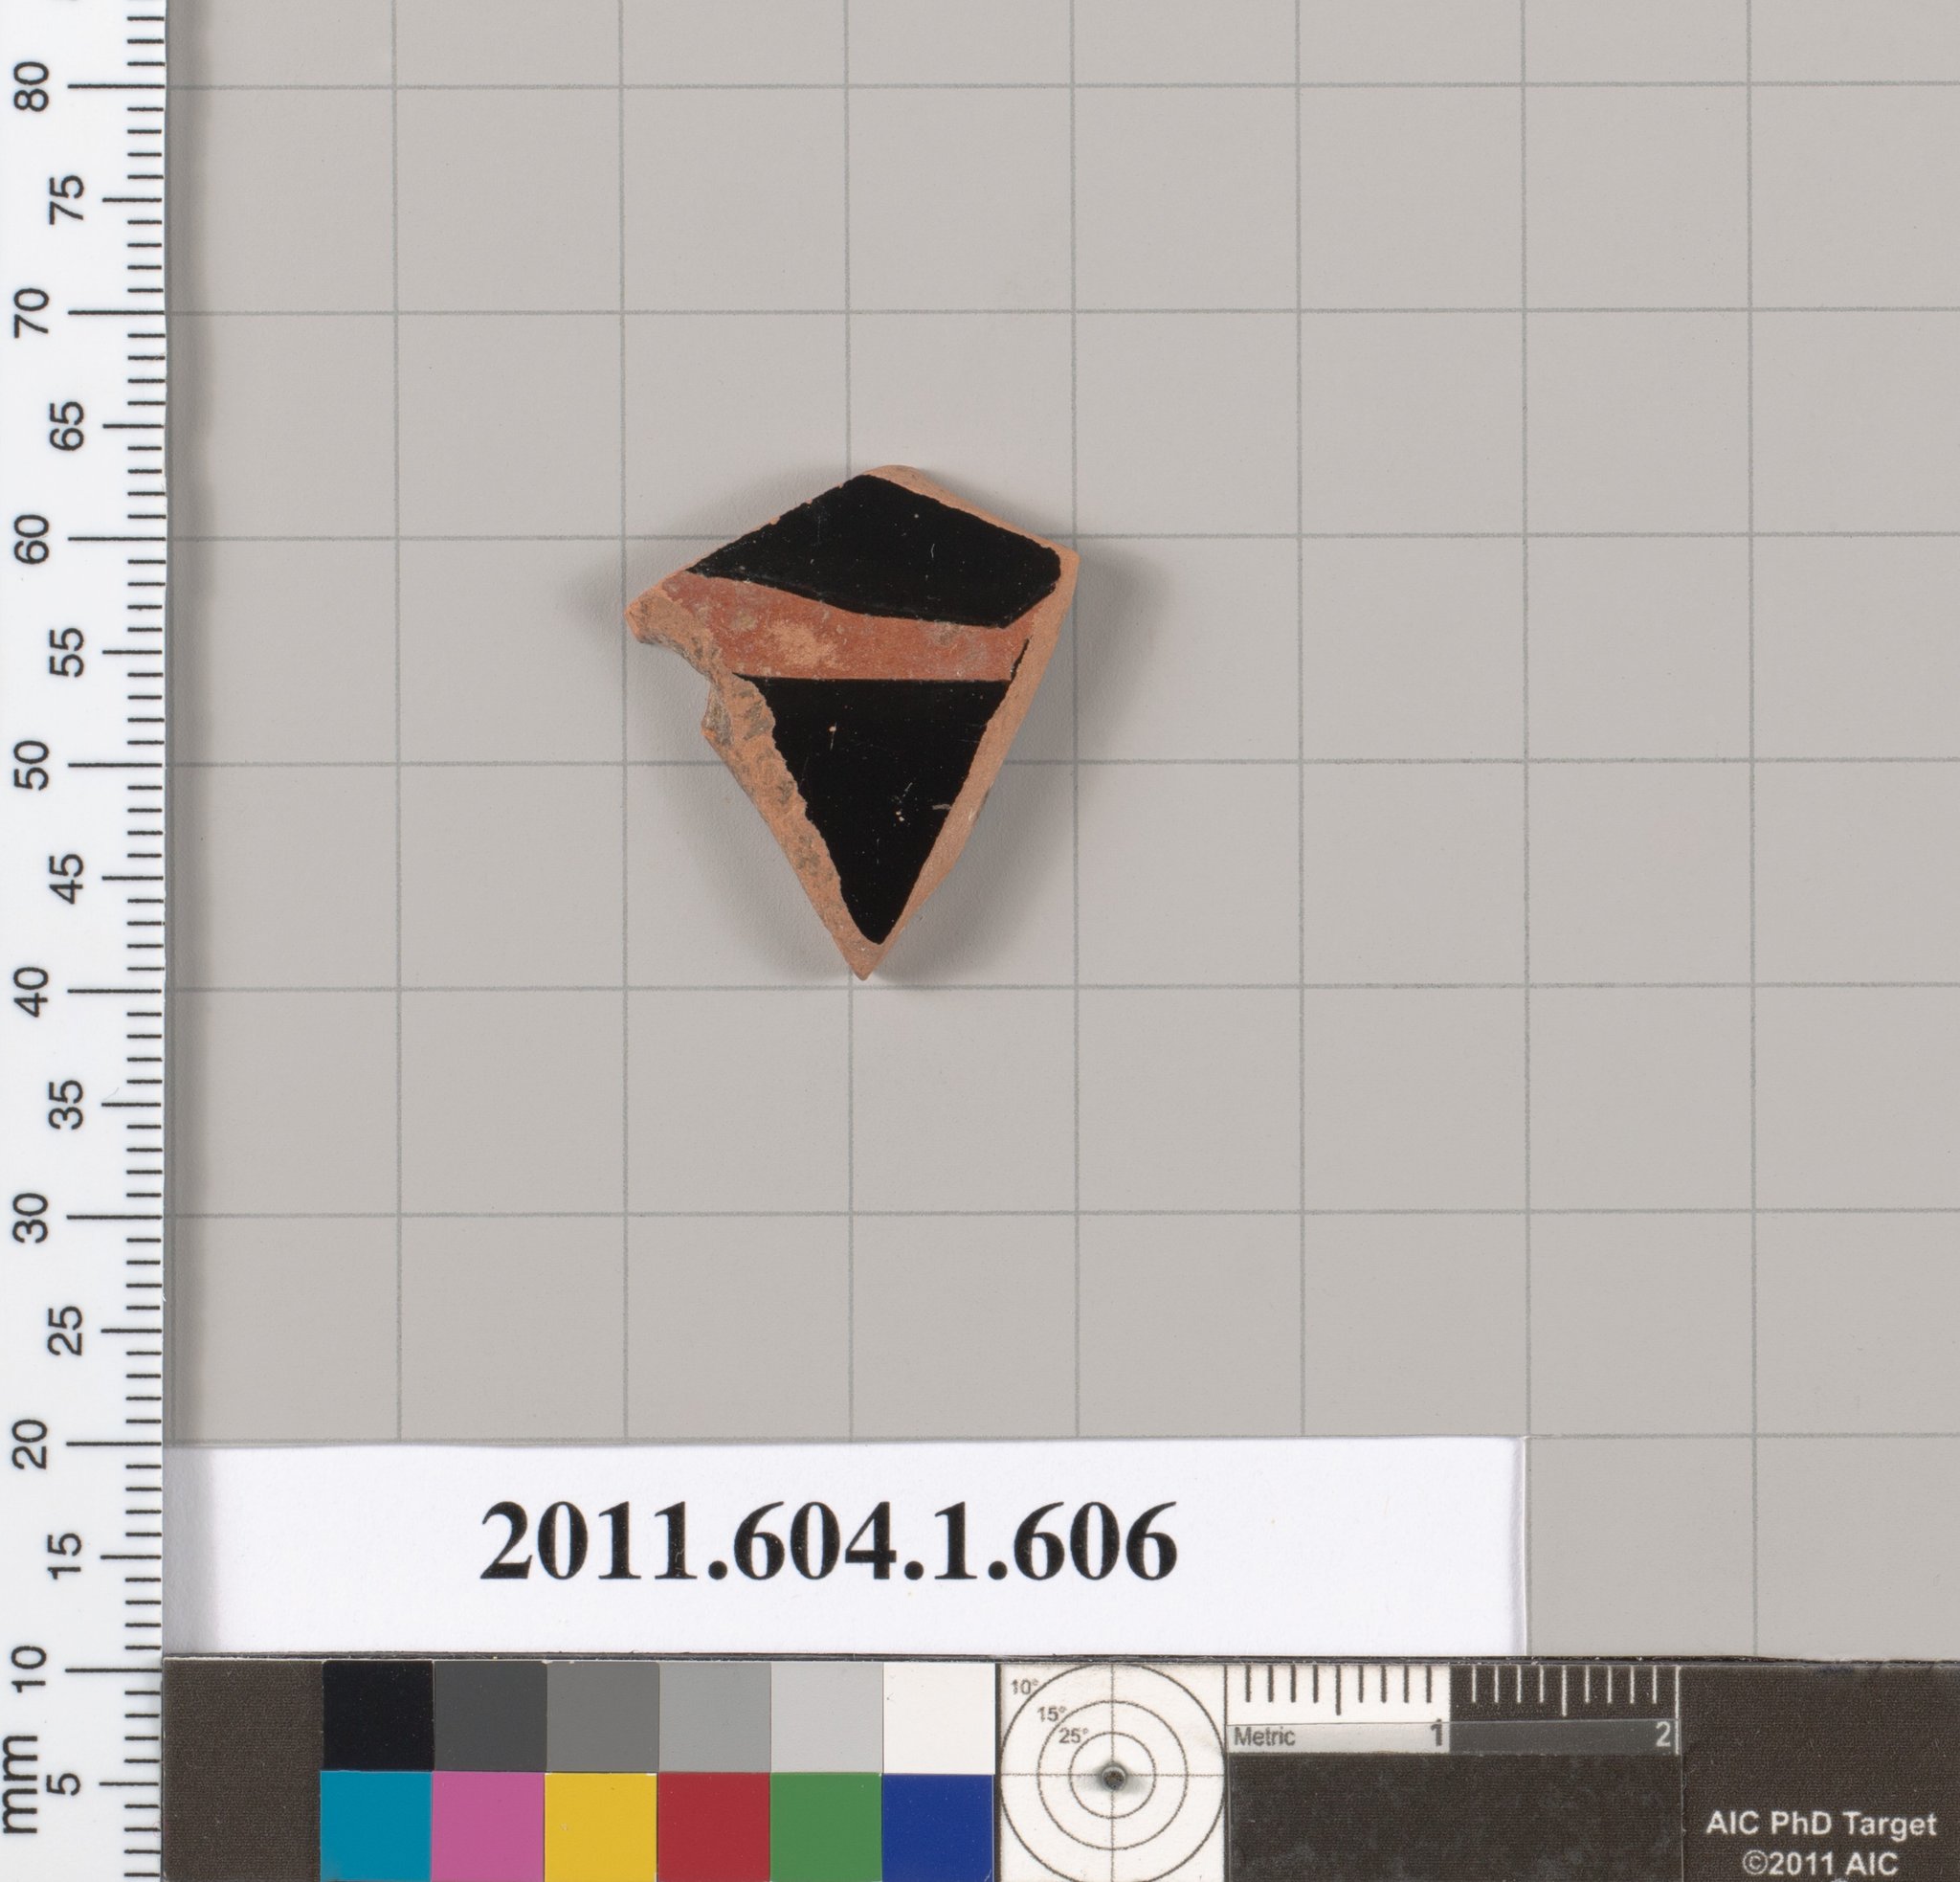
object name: kylix fragment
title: Terracotta fragment of a kylix (drinking cup)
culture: greek, attic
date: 475-451 BCE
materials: terracotta